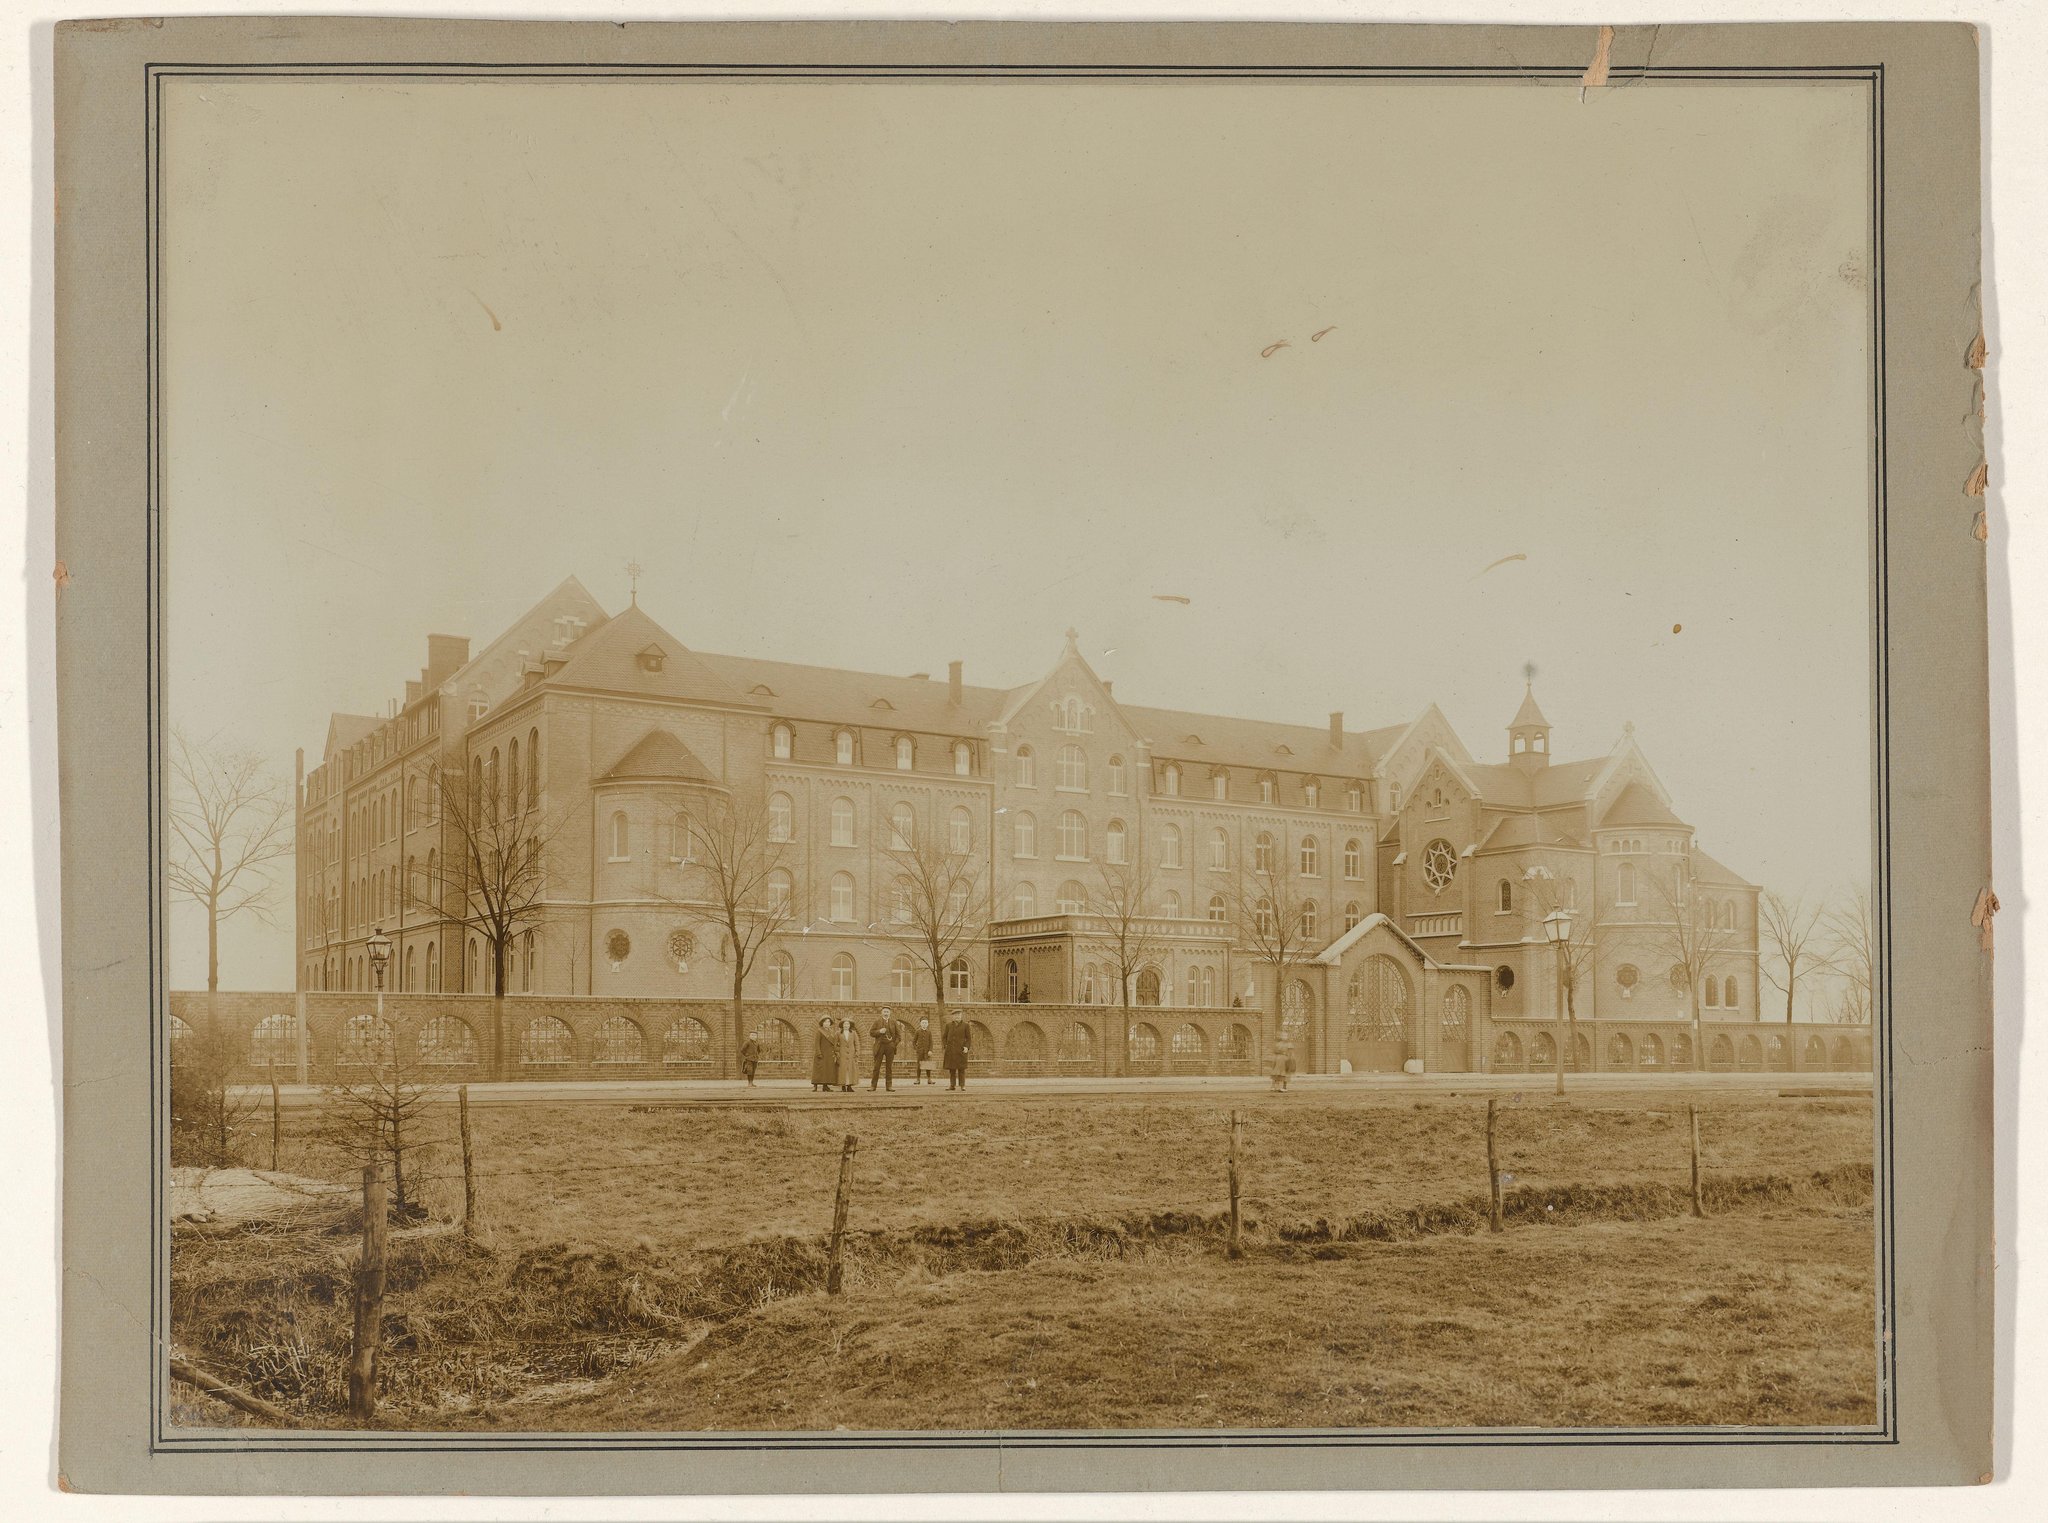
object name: photograph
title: Klooster of Internaat in Neo-Romaanse stijl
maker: Anonymous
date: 1860-1880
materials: cardboard, photographic support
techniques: albumen print